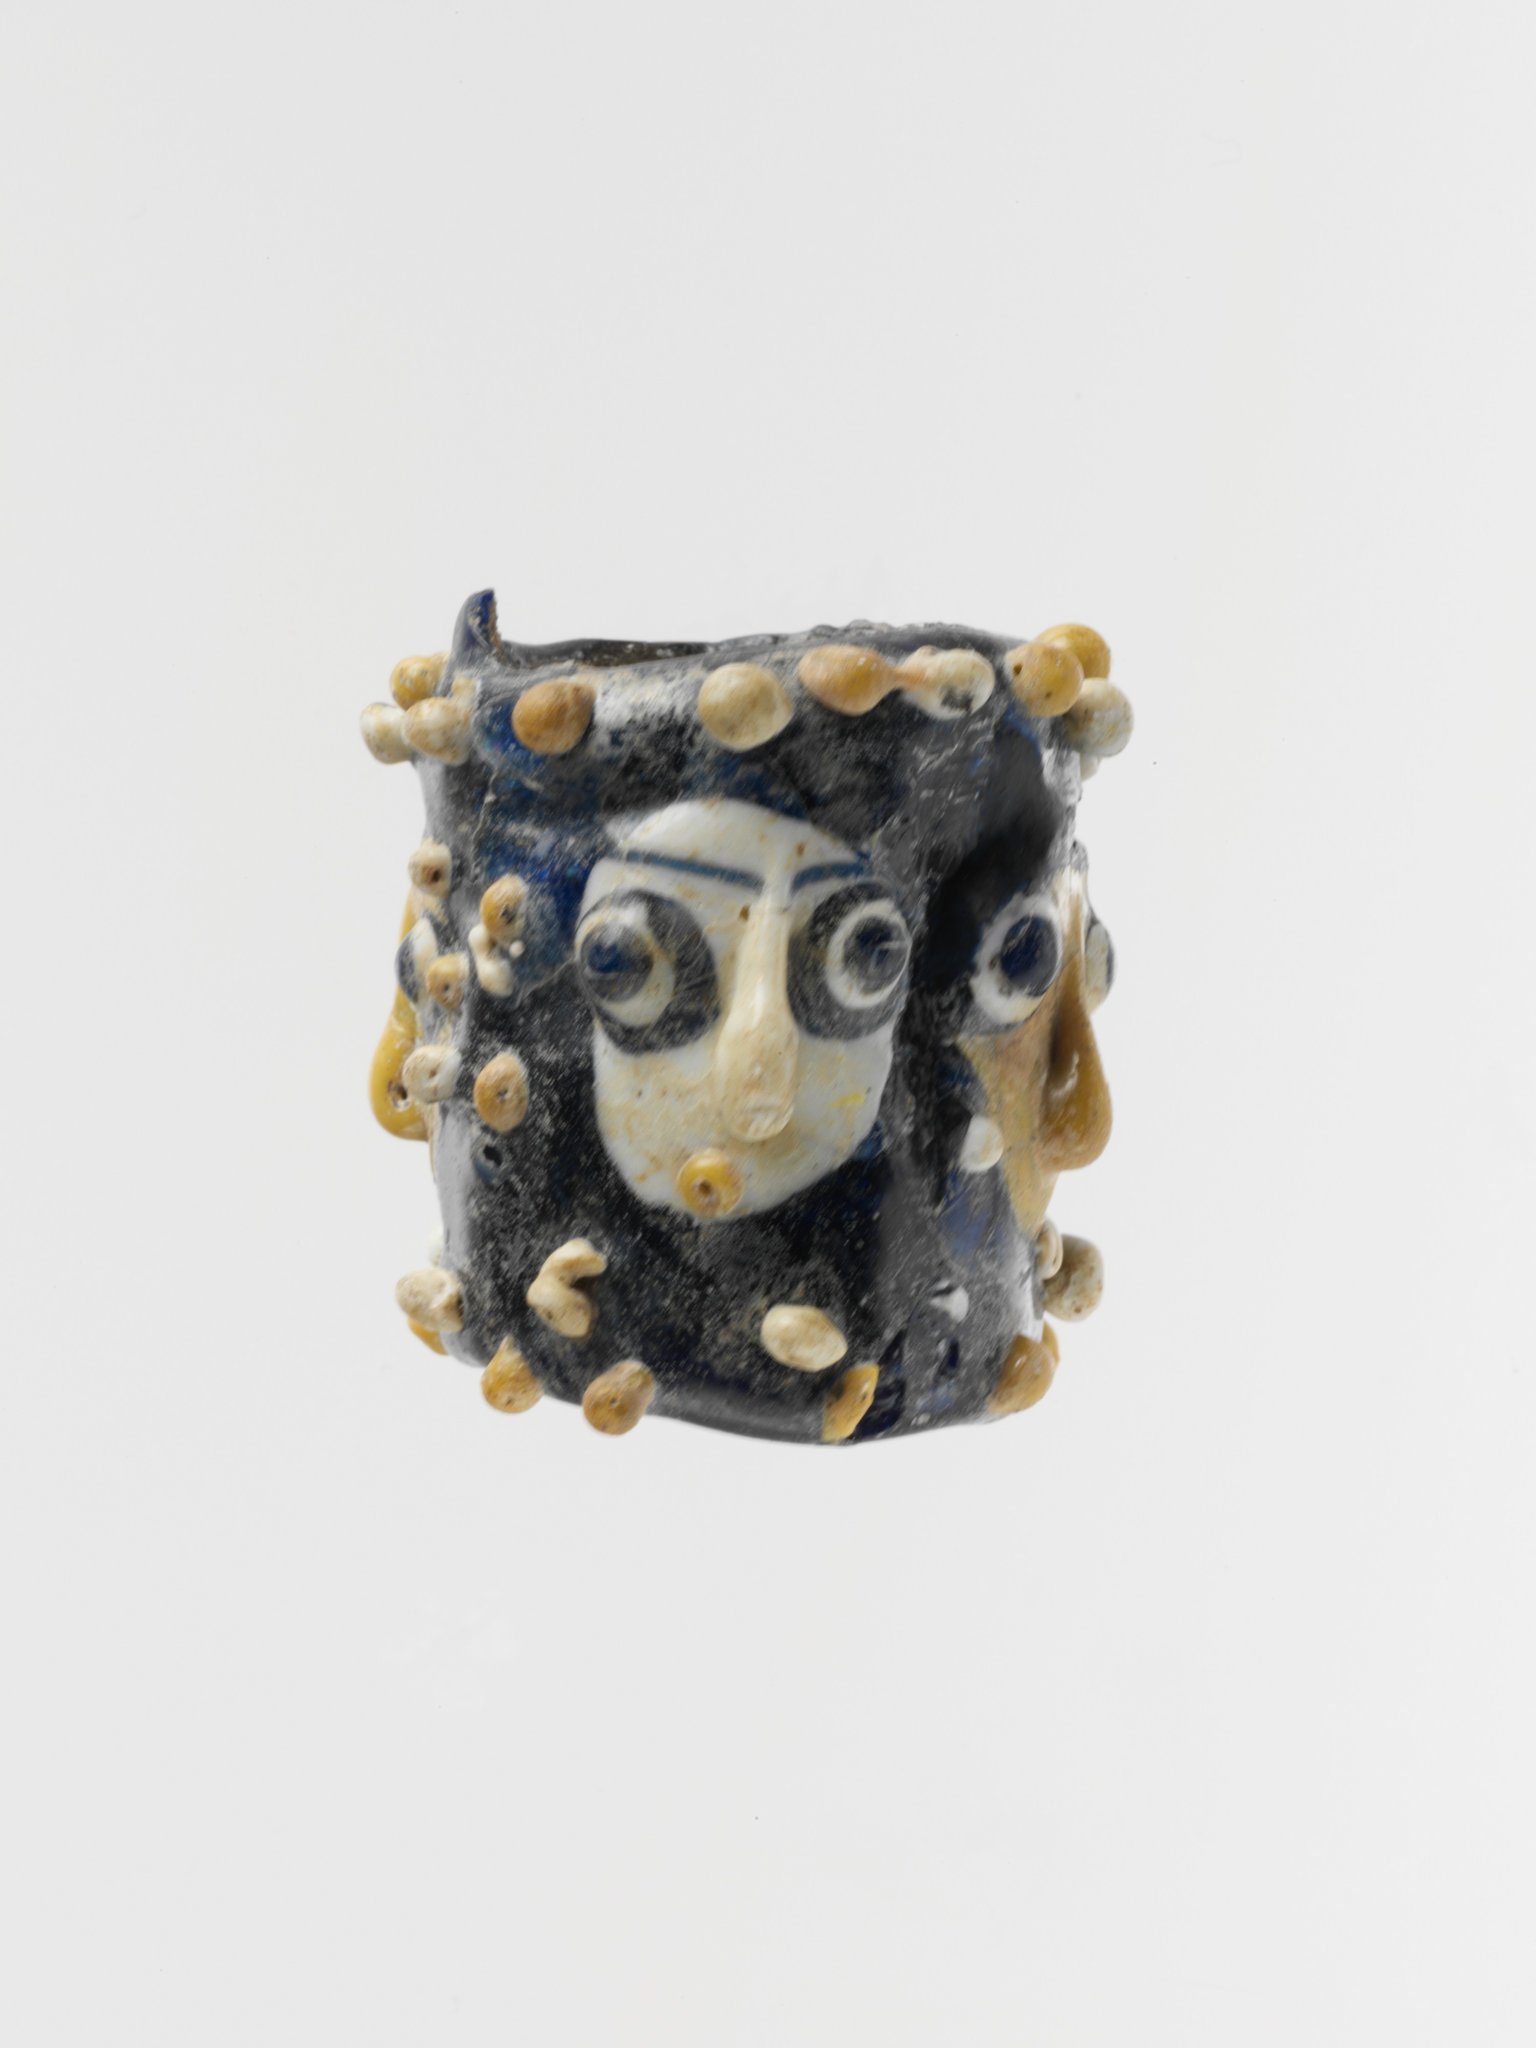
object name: face bead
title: Glass face bead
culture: carthaginian or phoenician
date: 434-135 BCE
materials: glass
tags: faces